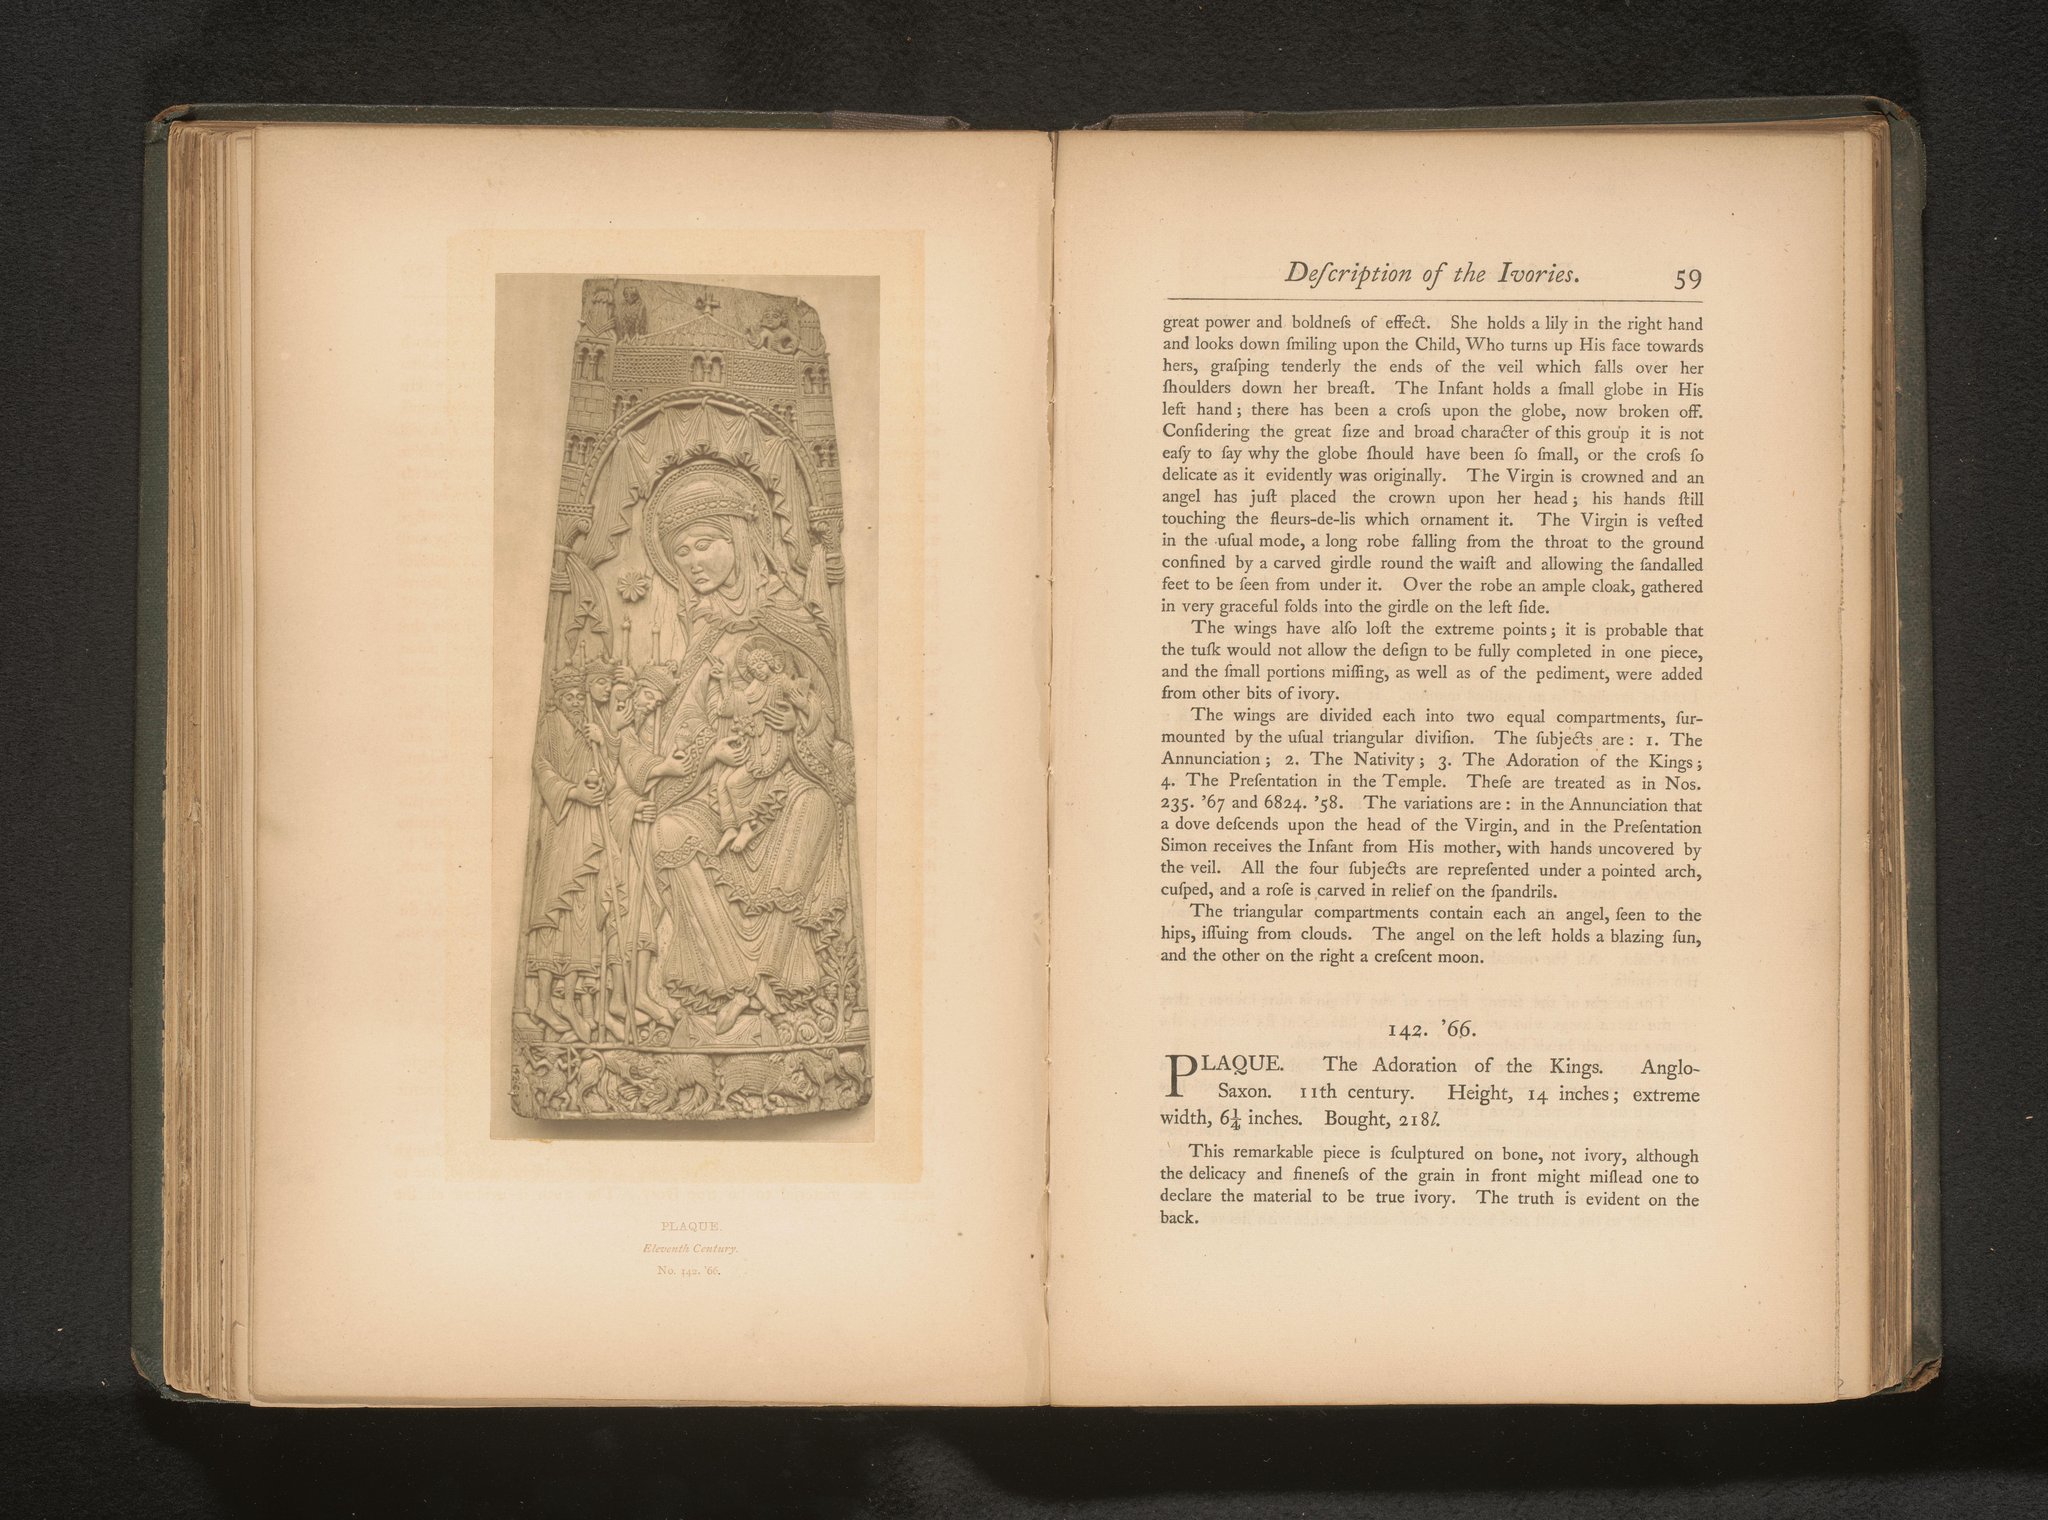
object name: photomechanical print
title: Plaque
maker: Anonymous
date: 1867-1872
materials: paper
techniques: woodburytype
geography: london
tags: adoration of the kings: the wise men present their gifts to the christ-child (gold, frankincense and myrrh), sculpture (+ relief ~ sculpture)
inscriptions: number: ‘No. 142. '66.’, inscription: ‘Eleventh Century.’